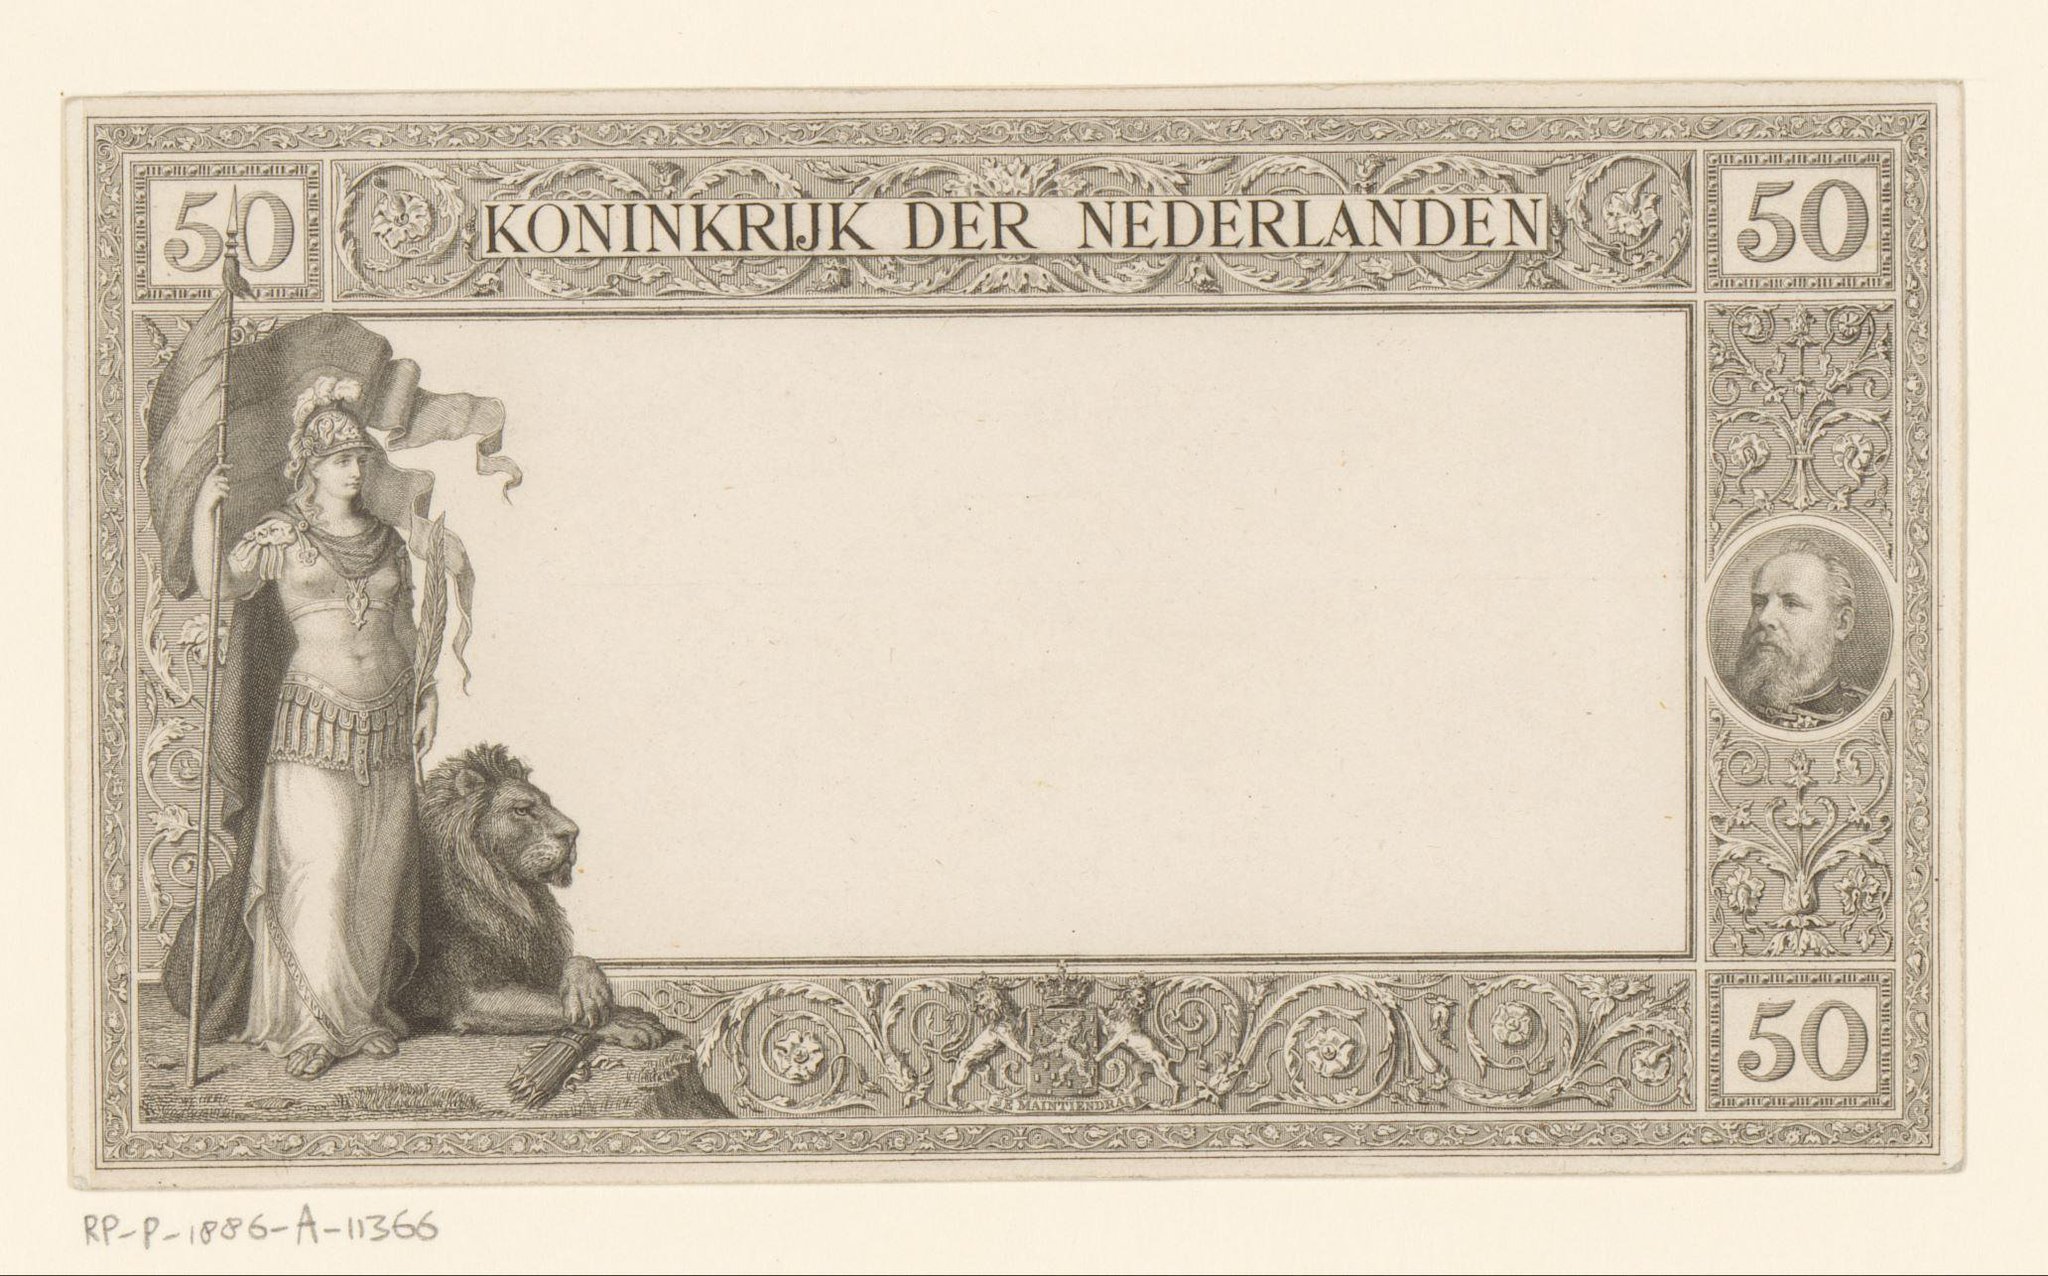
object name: print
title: Muntbiljet van 50 gulden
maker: rudolf stang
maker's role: draughtsman, painter, print maker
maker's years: 1831-1927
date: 1884-1886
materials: paper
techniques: engraving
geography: netherlands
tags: bank-note, money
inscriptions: collector's mark: Lugt 2228